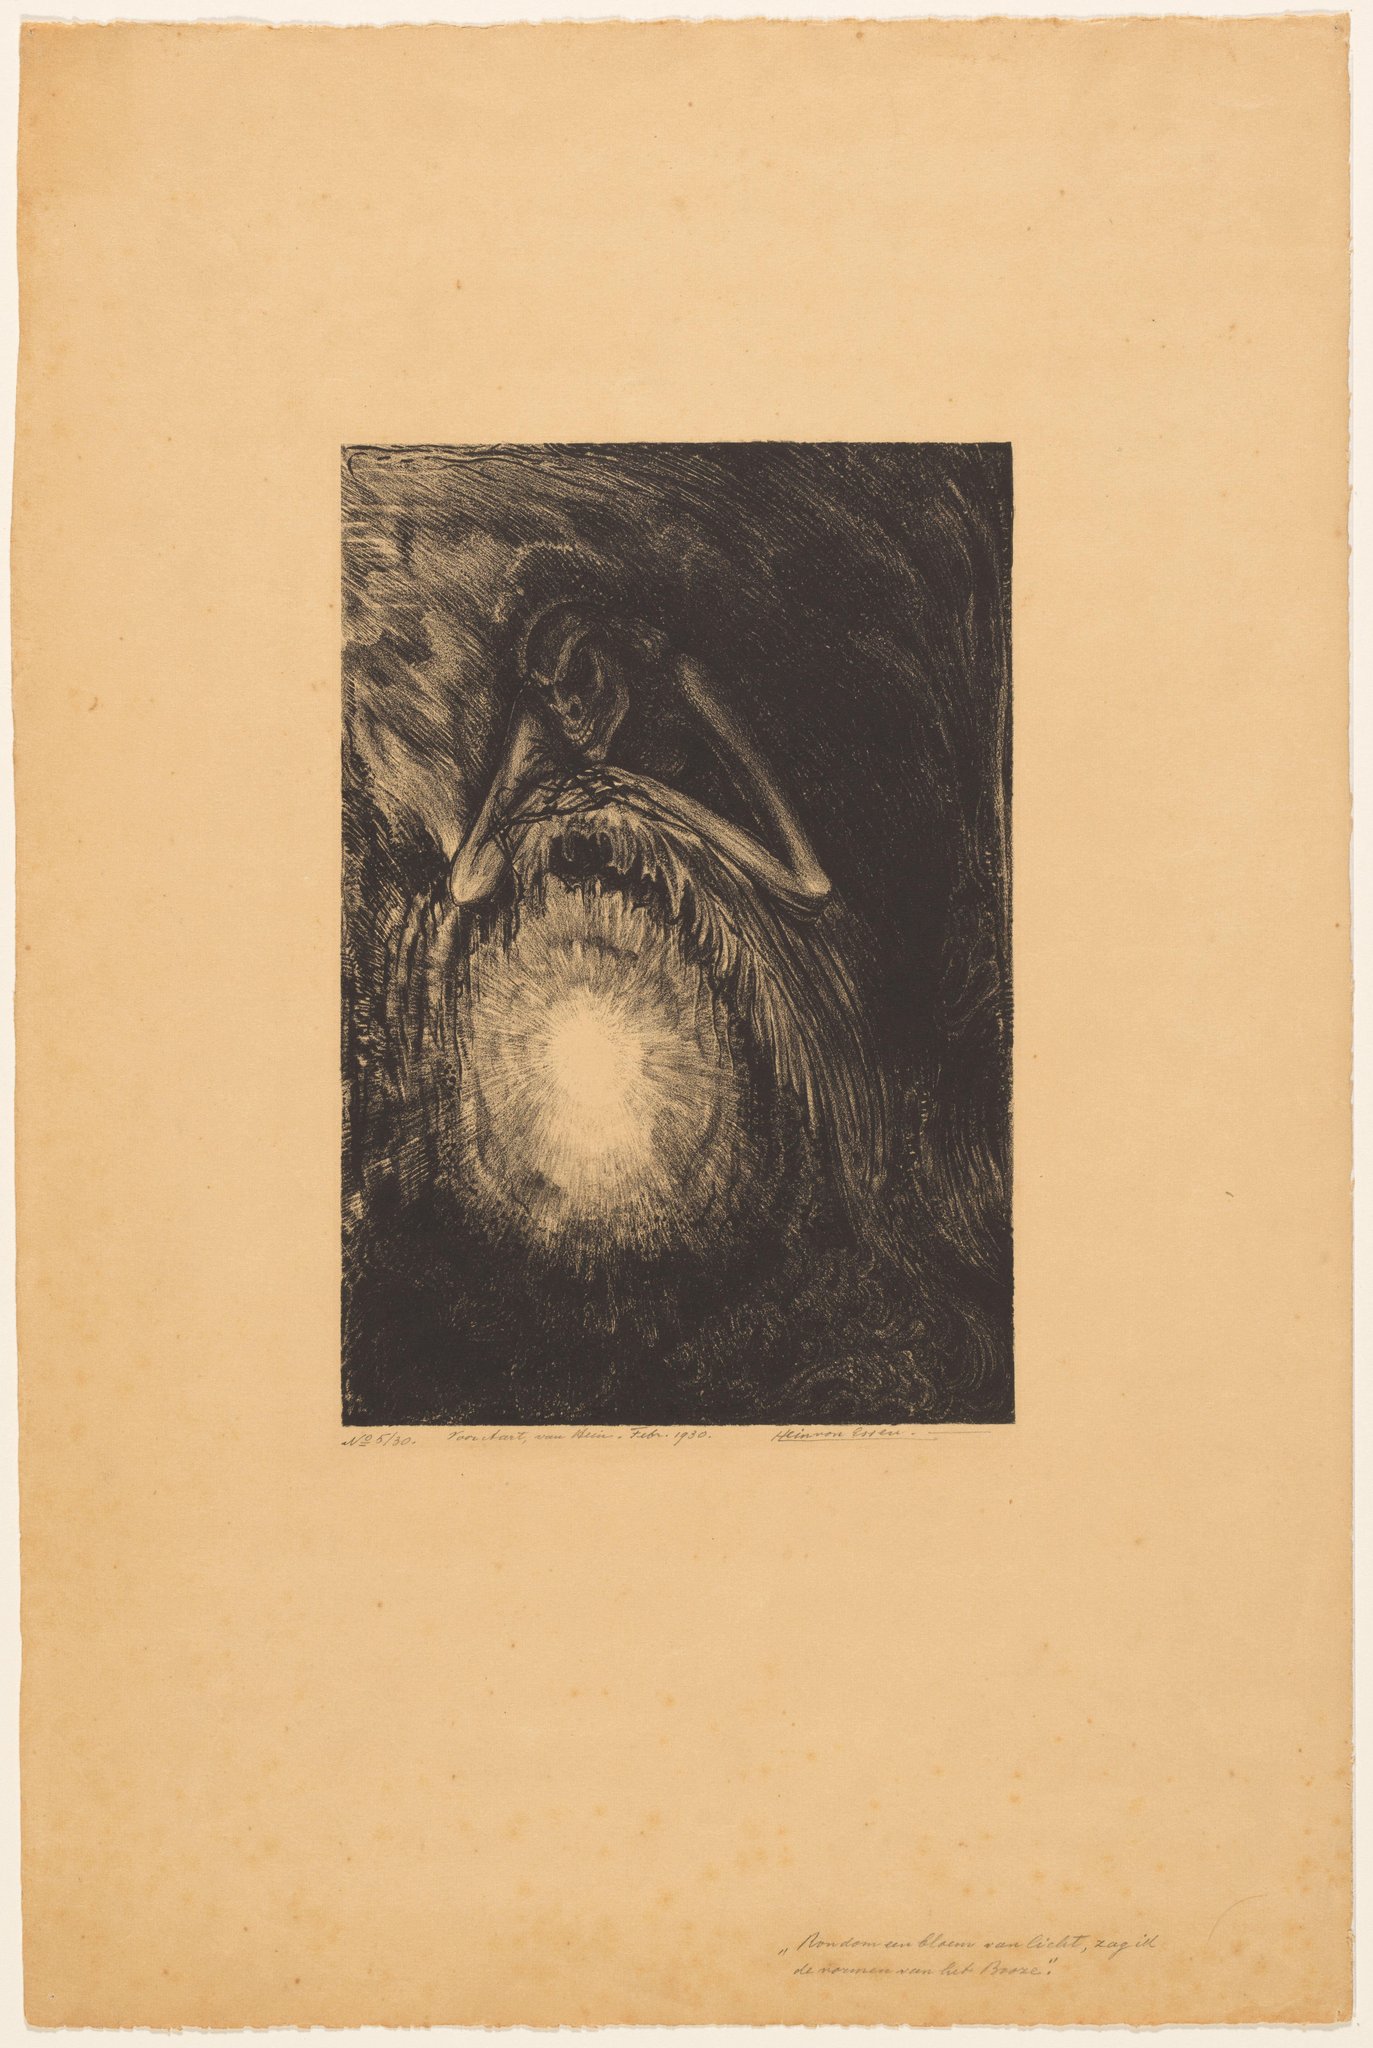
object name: print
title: Rondom een blauw van licht, zag ik de vormen van het Booze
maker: hein von essen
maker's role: print maker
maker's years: 1886-1947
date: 1928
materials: paper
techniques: lithograph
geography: the hague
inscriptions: inscription: ‘No 5/30. Voor Aart van Hein. Febr. 1930 / “Rondom een blauw van licht, zag ik / de vormen van het Booze. / Hein von Essen’, inscription: ‘"Rondom een blauw van licht, zag ik / de vormen van het Booze"’, watermark: ‘Holland’